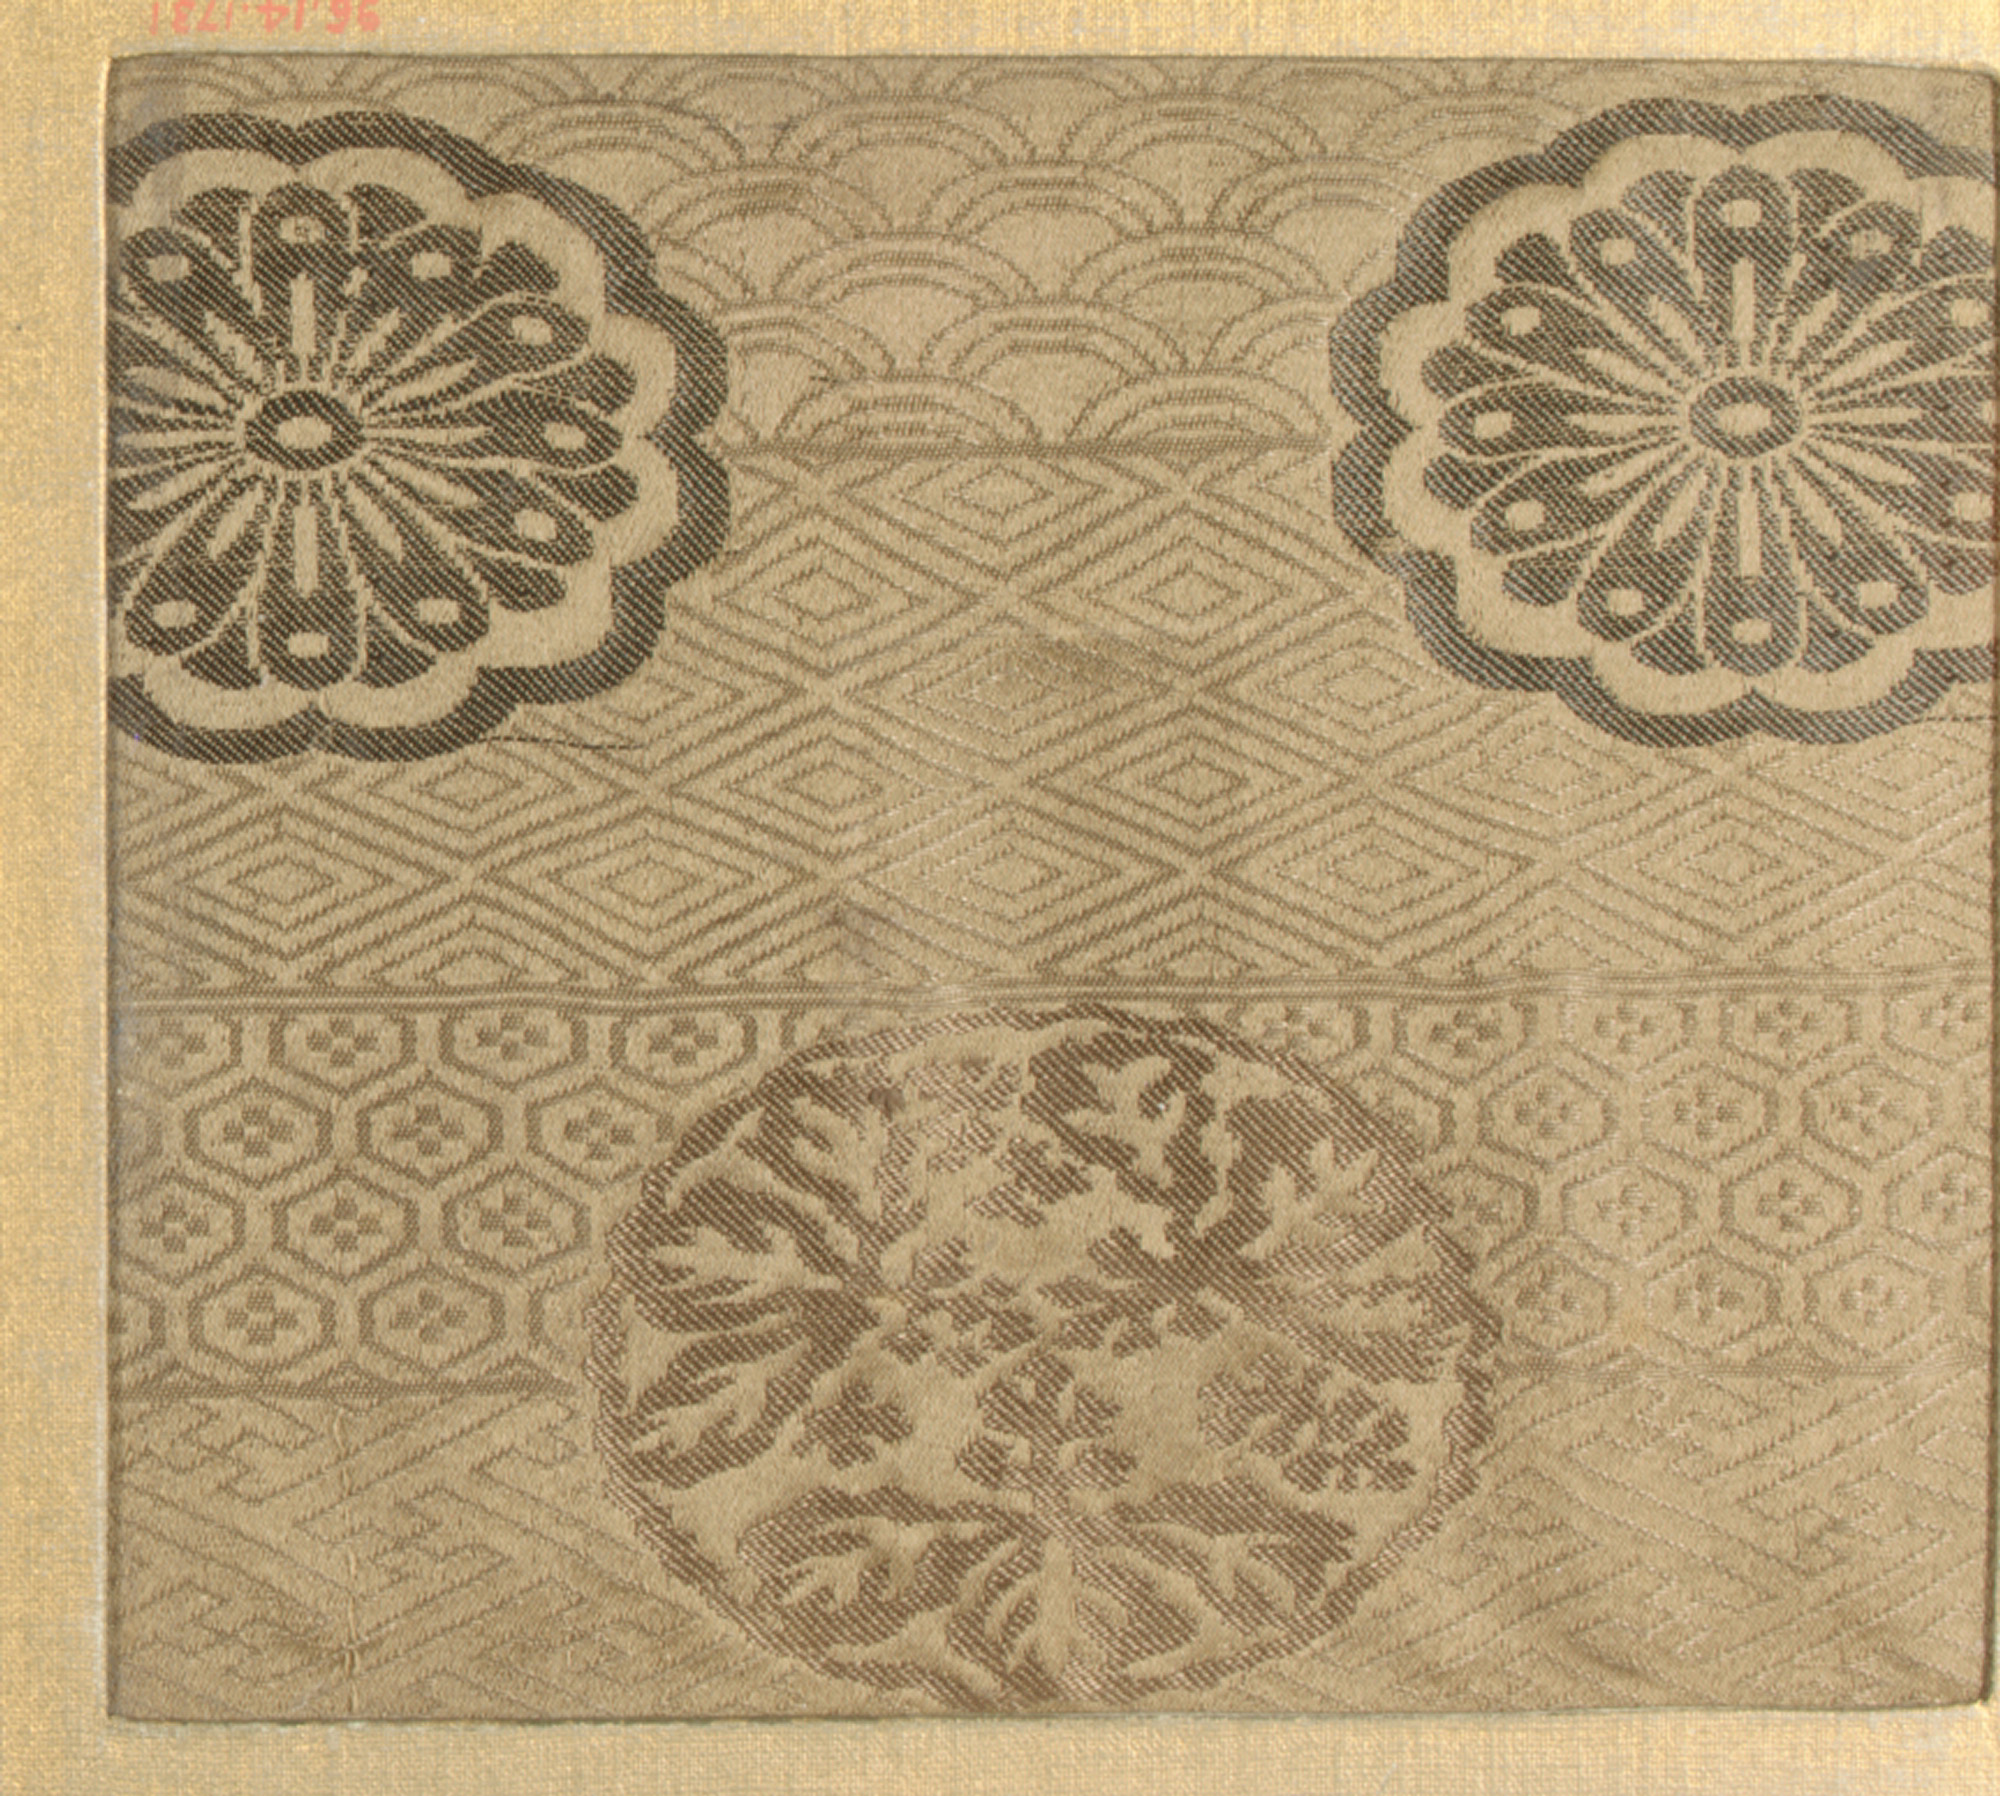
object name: piece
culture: japanese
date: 1701-1900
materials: silk